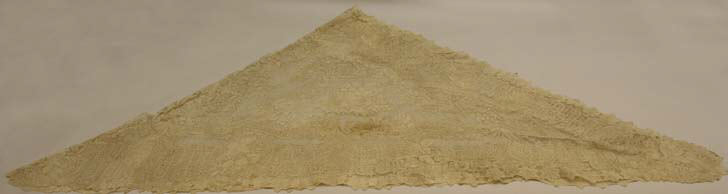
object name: shawl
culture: belgian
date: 1834-1866